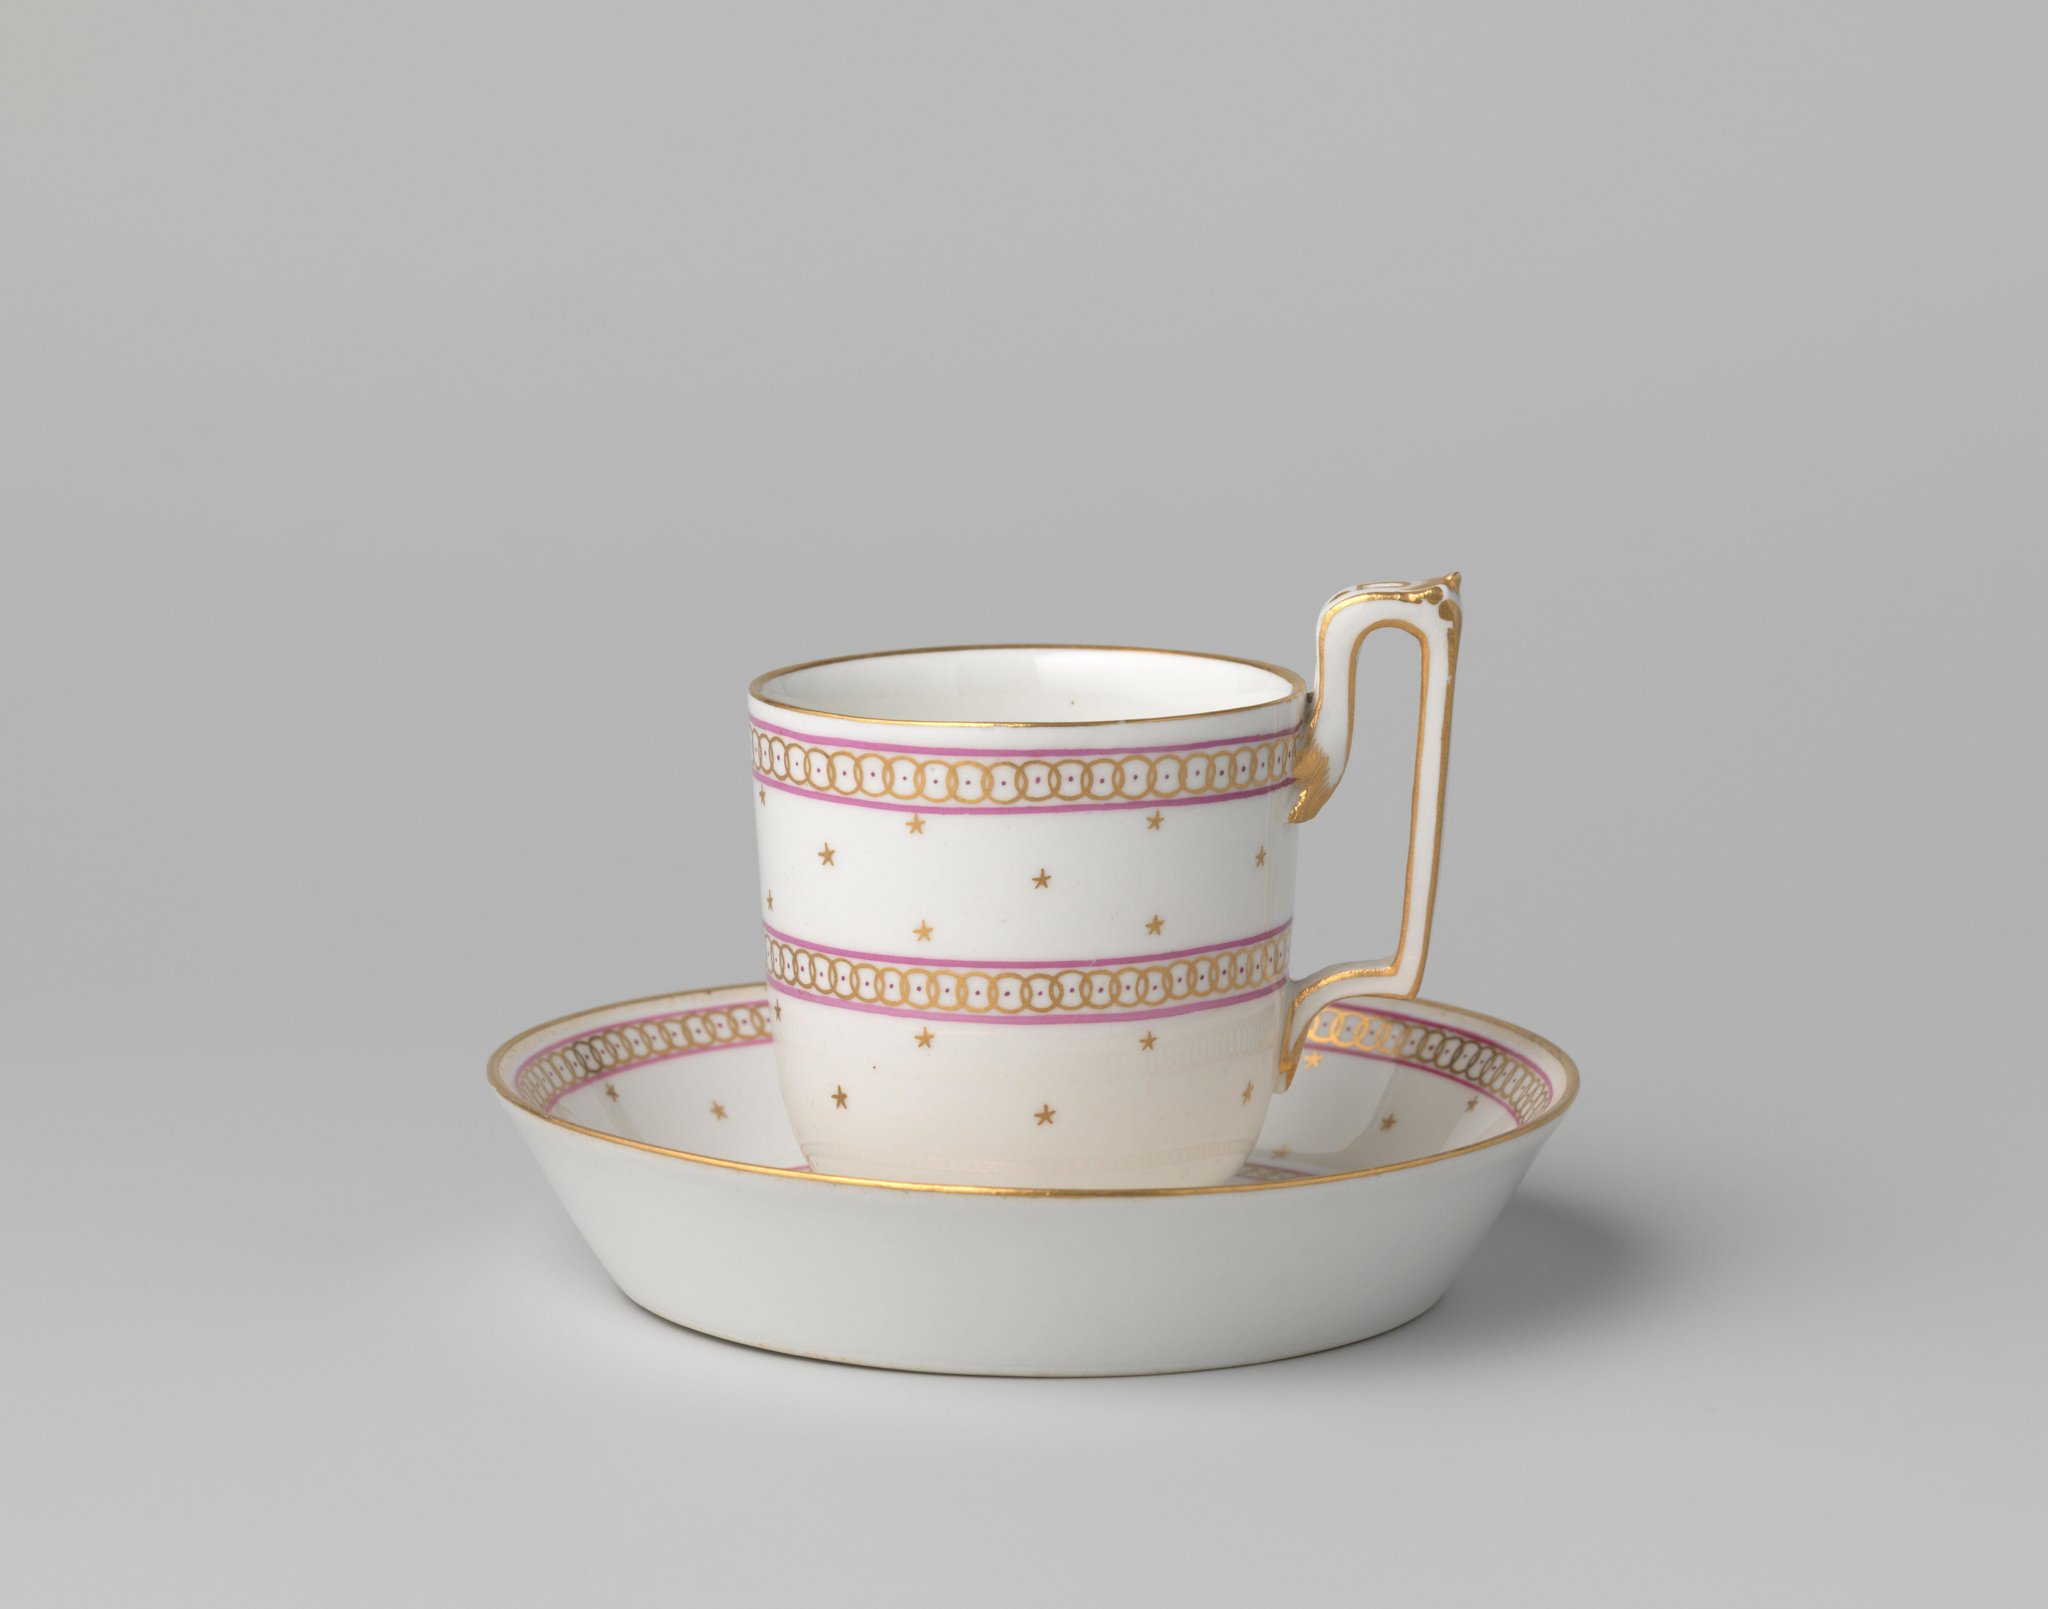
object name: kop en schotel, kop en schotel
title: Saucer with stars and ornamental borders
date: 1791-1801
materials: glaze, gold, paint, porcelain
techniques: firing, forming, gilding, turning, vitrification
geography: vienna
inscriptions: mark: ‘schild/ 101/ 39/ 91’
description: Delen van een cilindervormig koffieservies bestaande uit een kan (A) en 6 koppen en schotels (B t/m G) beschilderd in paars en goud met sterretjes en kettingen. Gemerkt met een fabrieksmerk in onderglazuurblauw en ingegrift 801 26 (kan), 791 33 (koppen) 791 39 (schotels).